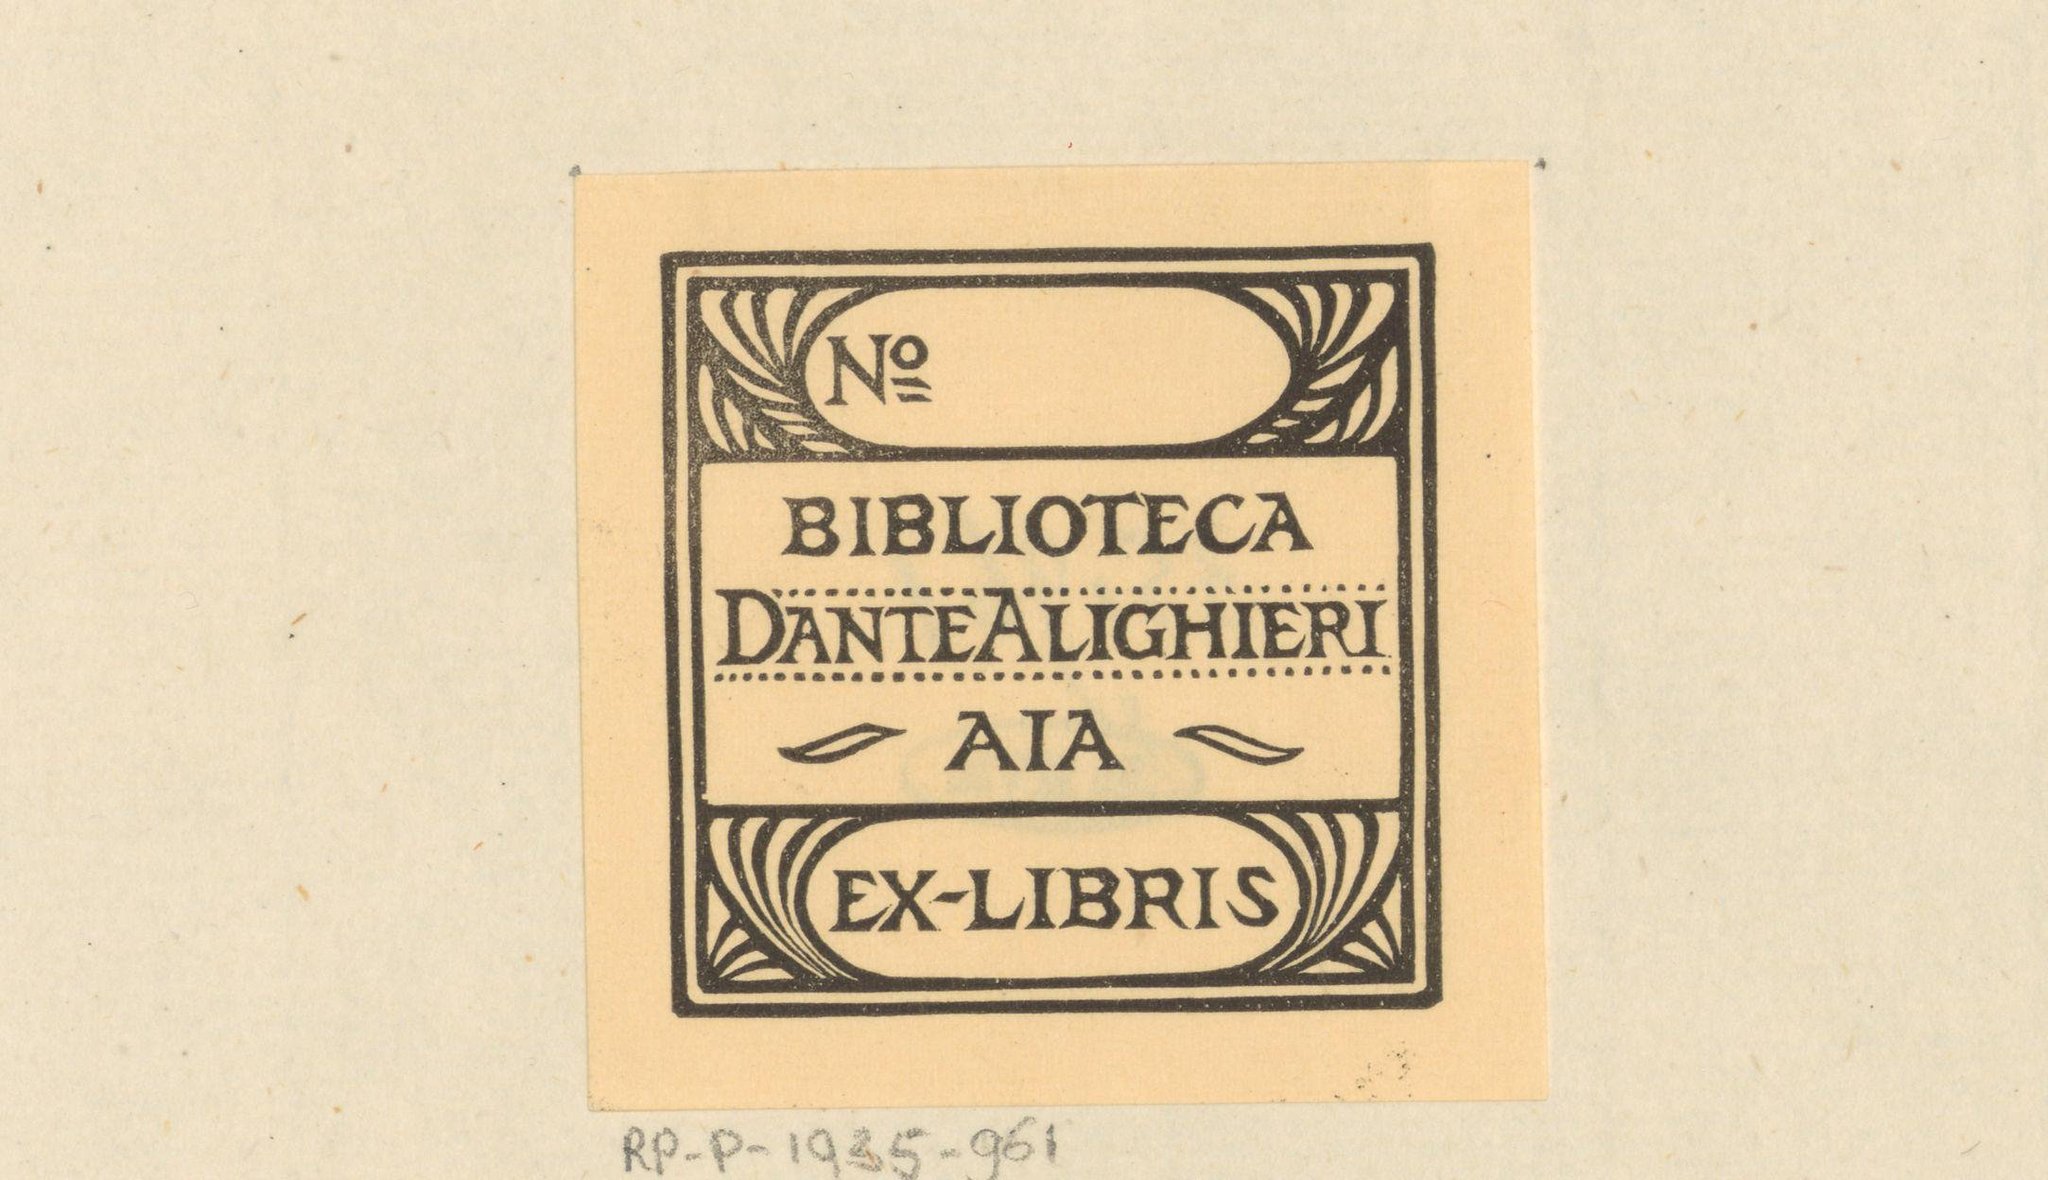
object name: bookplate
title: Ex libris van de Biblioteca Dante Alighieri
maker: julie de graag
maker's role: draughtsman, print maker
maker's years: 1877-1924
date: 1887-1924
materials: paper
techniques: woodcut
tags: biblioteca dante alighieri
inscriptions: collector's mark: Lugt 2228